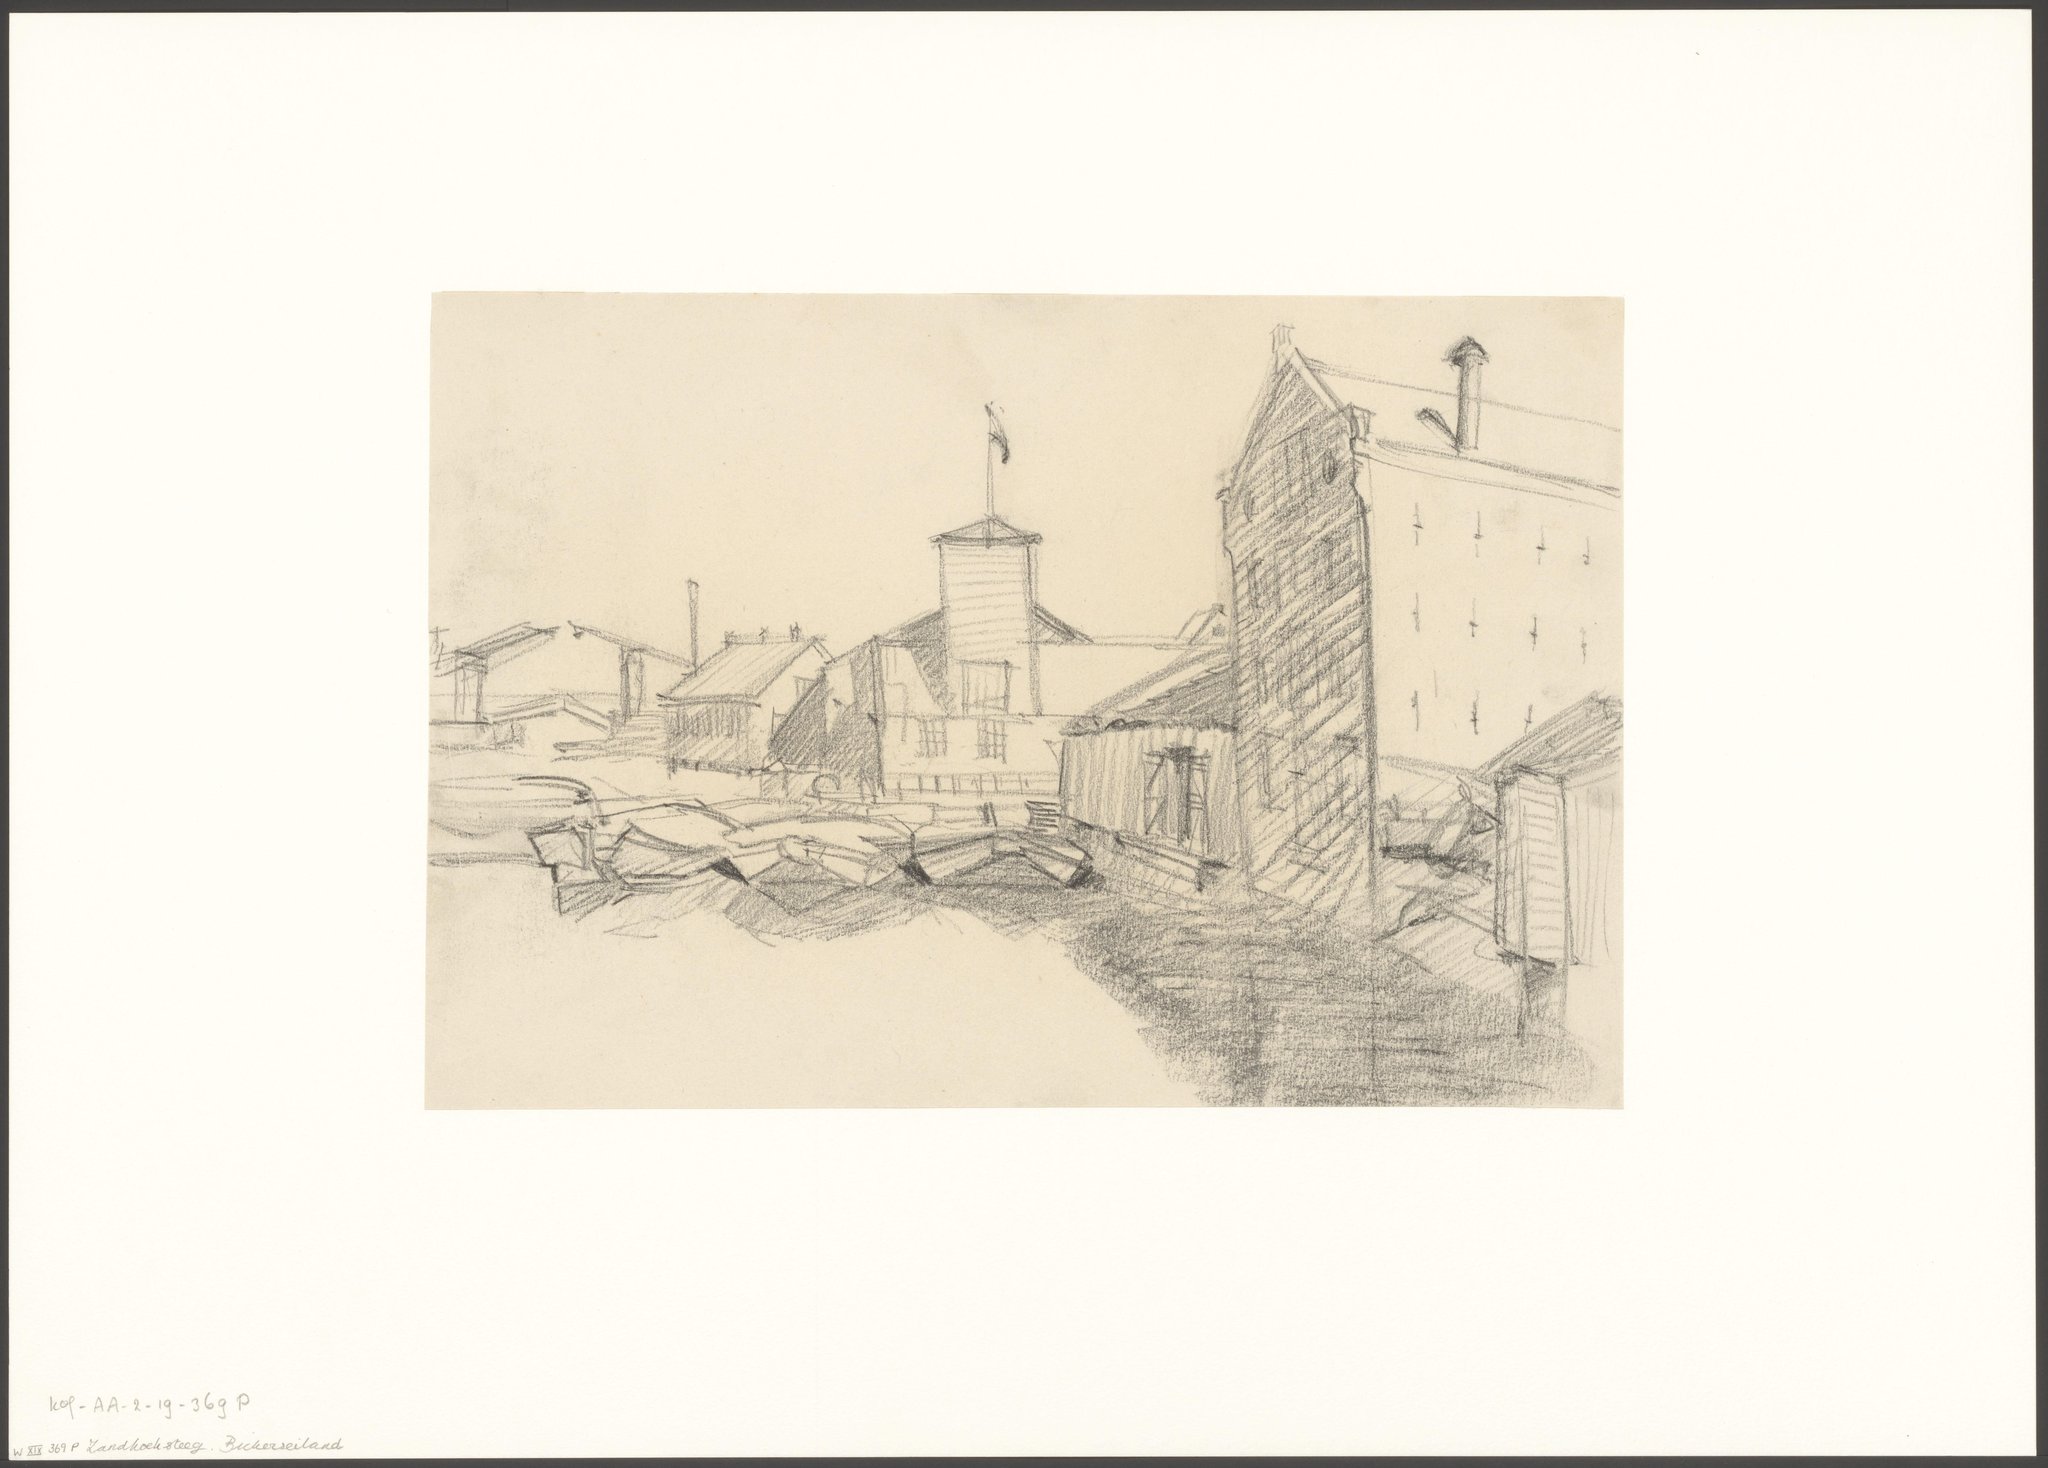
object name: drawing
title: Gezicht op de Zandhoek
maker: Anonymous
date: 1875-1975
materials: chalk, paper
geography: amsterdam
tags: city-view in general; 'veduta', canal, boat propelled by man or animal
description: Tekening binnen de Atlas Van Eck ingedeeld op wijknummer 19.